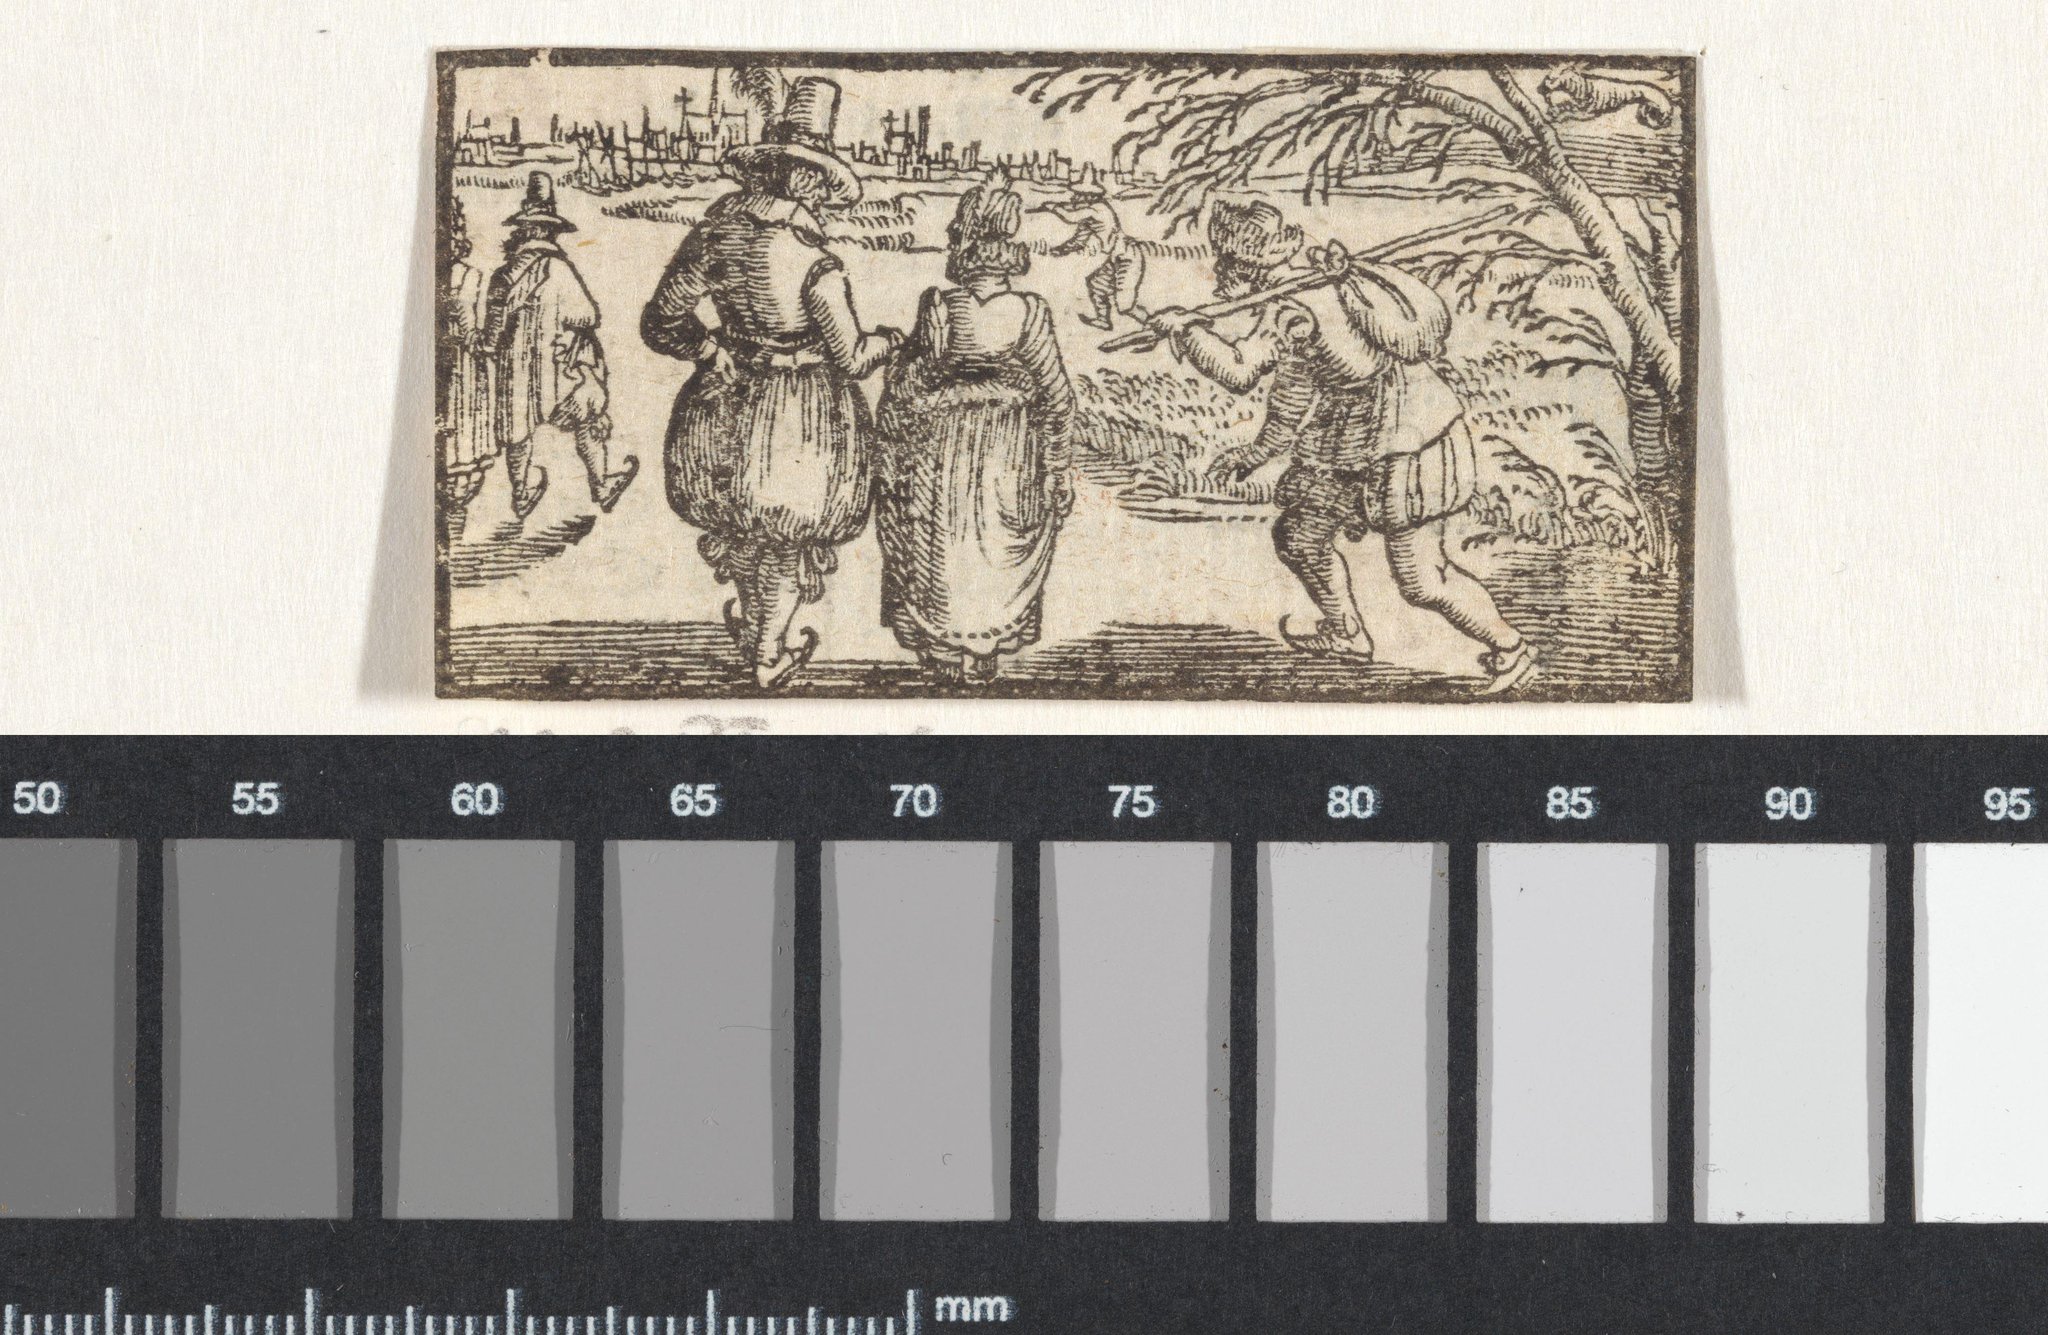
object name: print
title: Maanden van het jaar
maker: Anonymous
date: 1600-1699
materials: paper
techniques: letterpress printing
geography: netherlands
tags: december and its 'labours' (+ with capricorn (december)), skates (winter sports)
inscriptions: collector's mark: Lugt 2228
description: Mannen en vrouwen schaatsend op het ijs. Rechtsboven een steenbok.